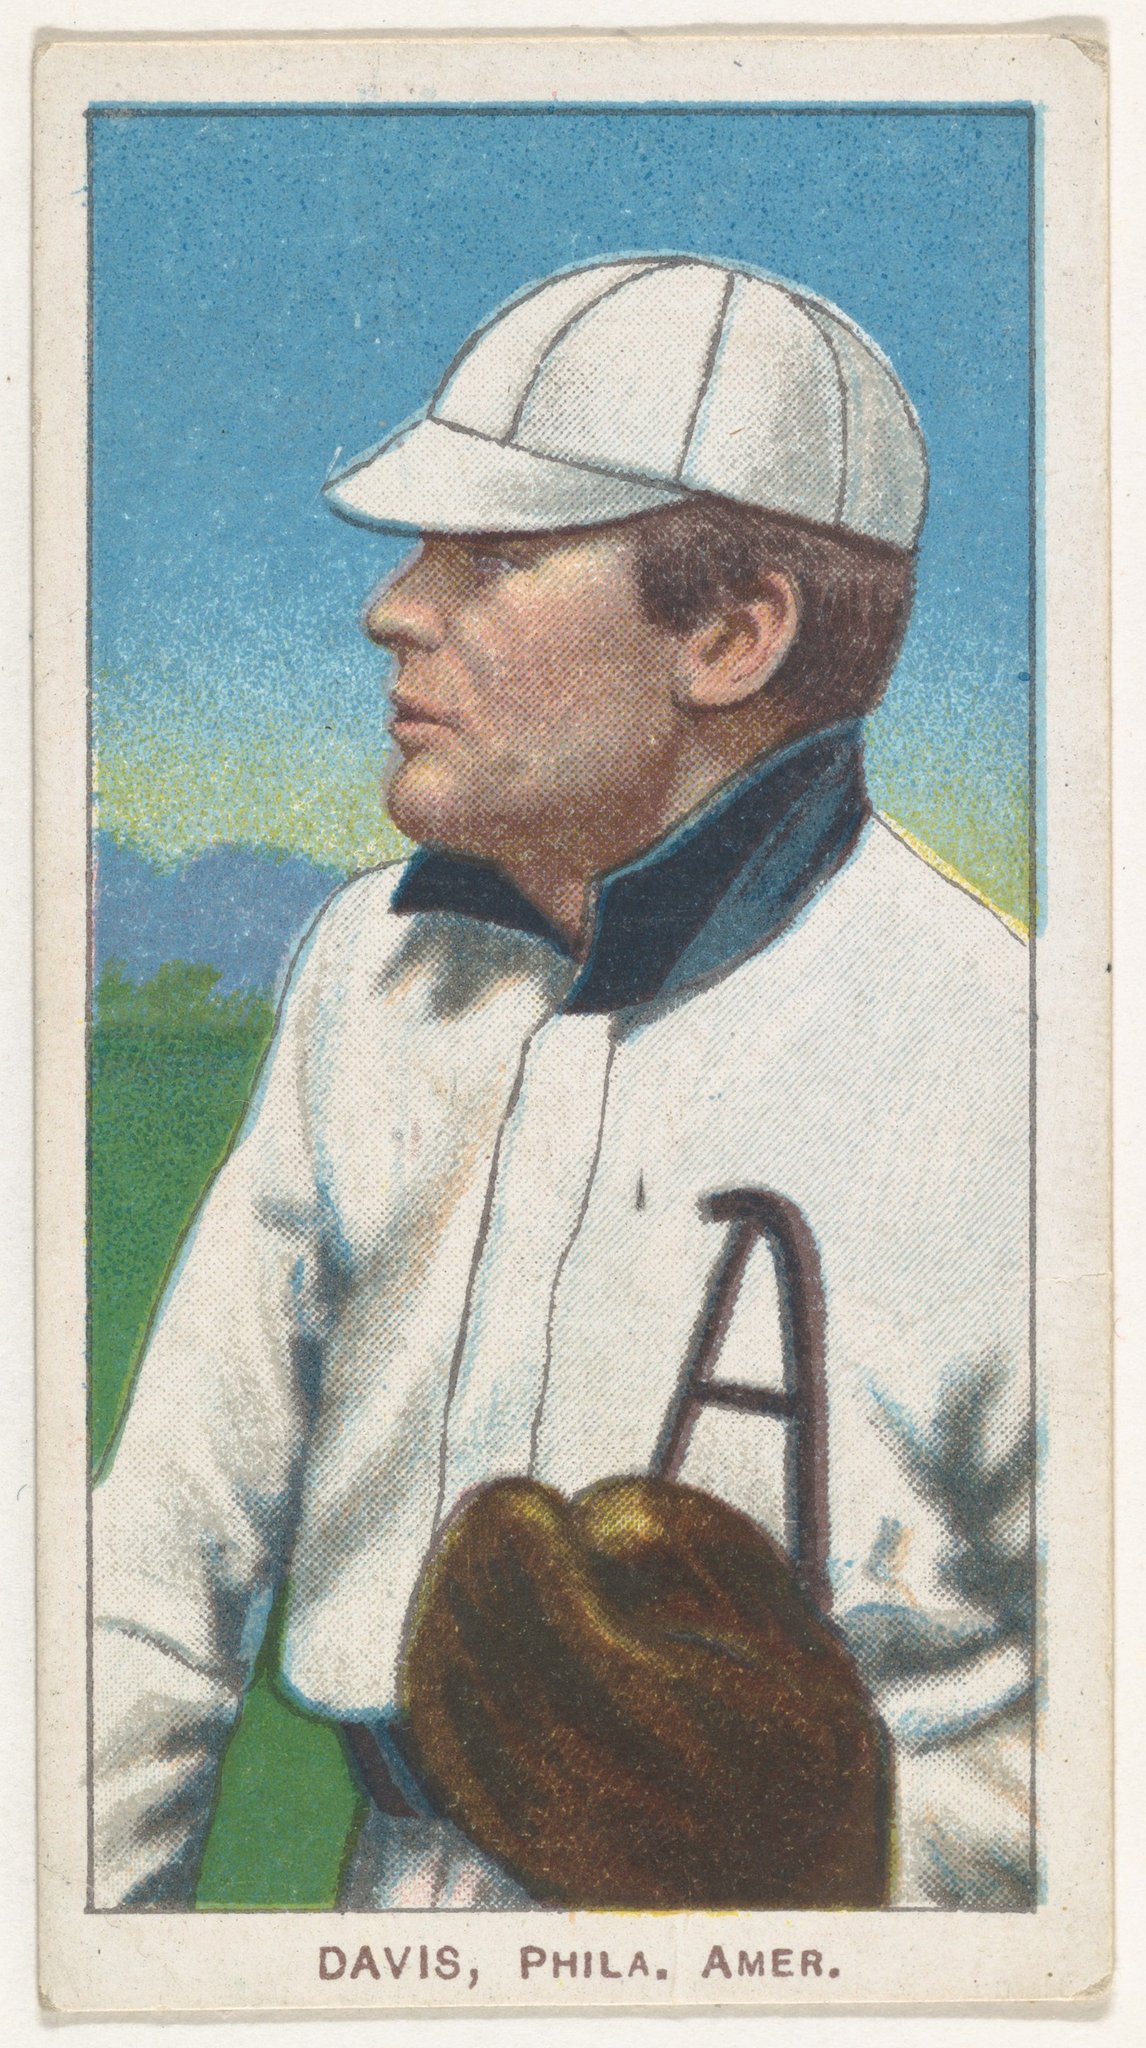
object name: baseball card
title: Davis, Philadelphia, American League, from the White Border series (T206) for the American Tobacco Company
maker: american tobacco company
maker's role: publisher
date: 1909-1911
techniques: color lithograph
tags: men,baseball,athletes